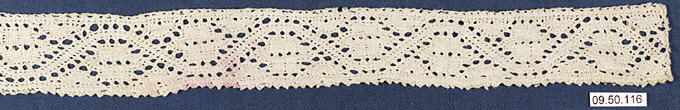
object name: strip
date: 1701-1800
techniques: lace